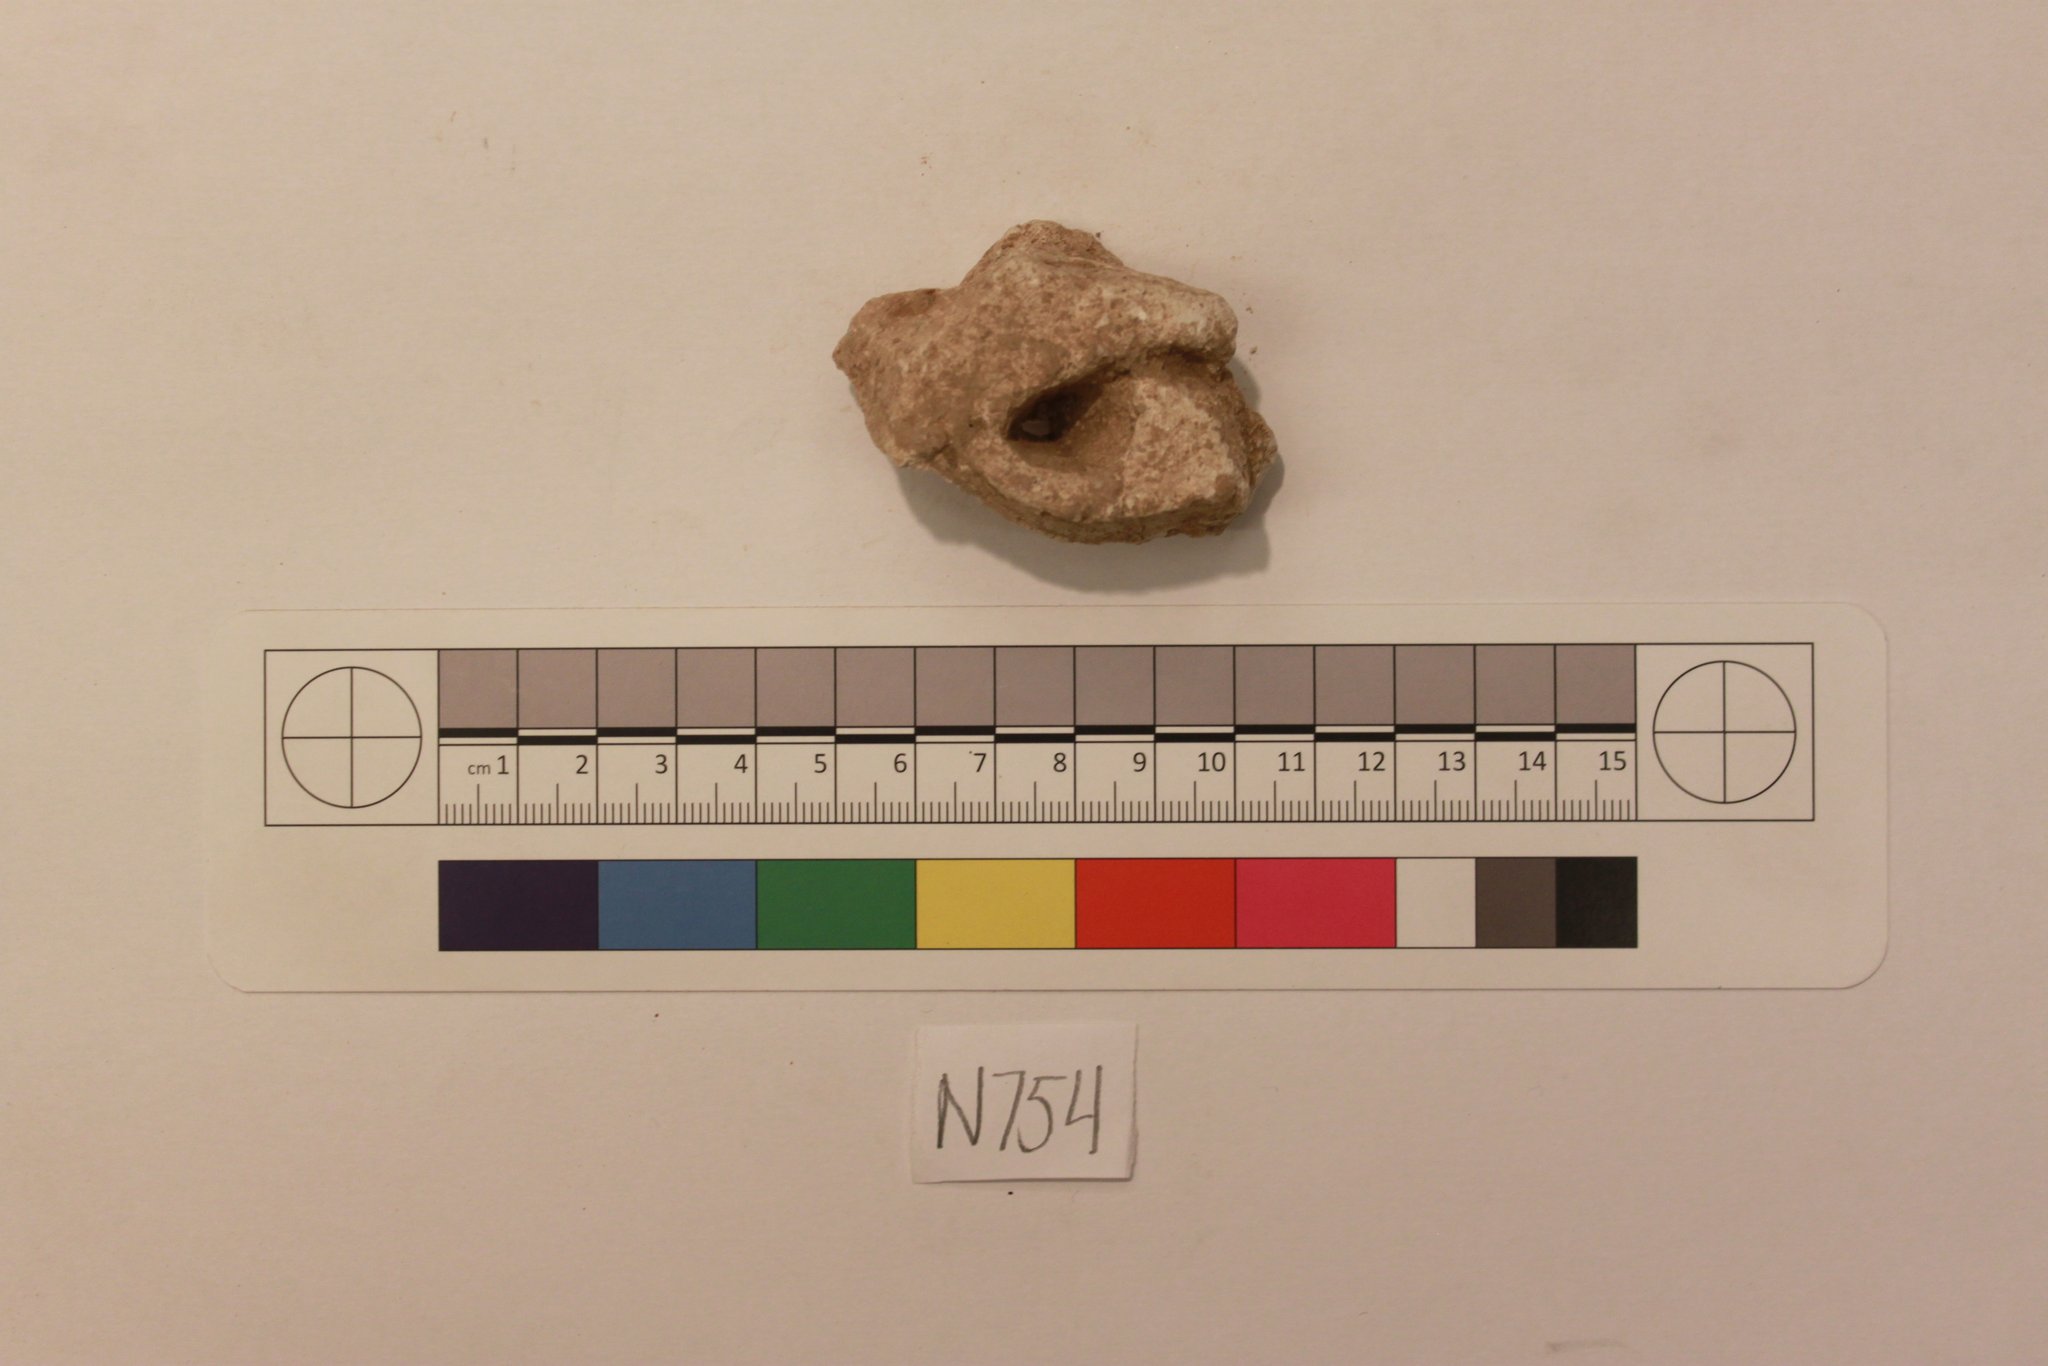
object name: fragment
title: Stucco Fragment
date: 701-1200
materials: plaster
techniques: carving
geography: iran